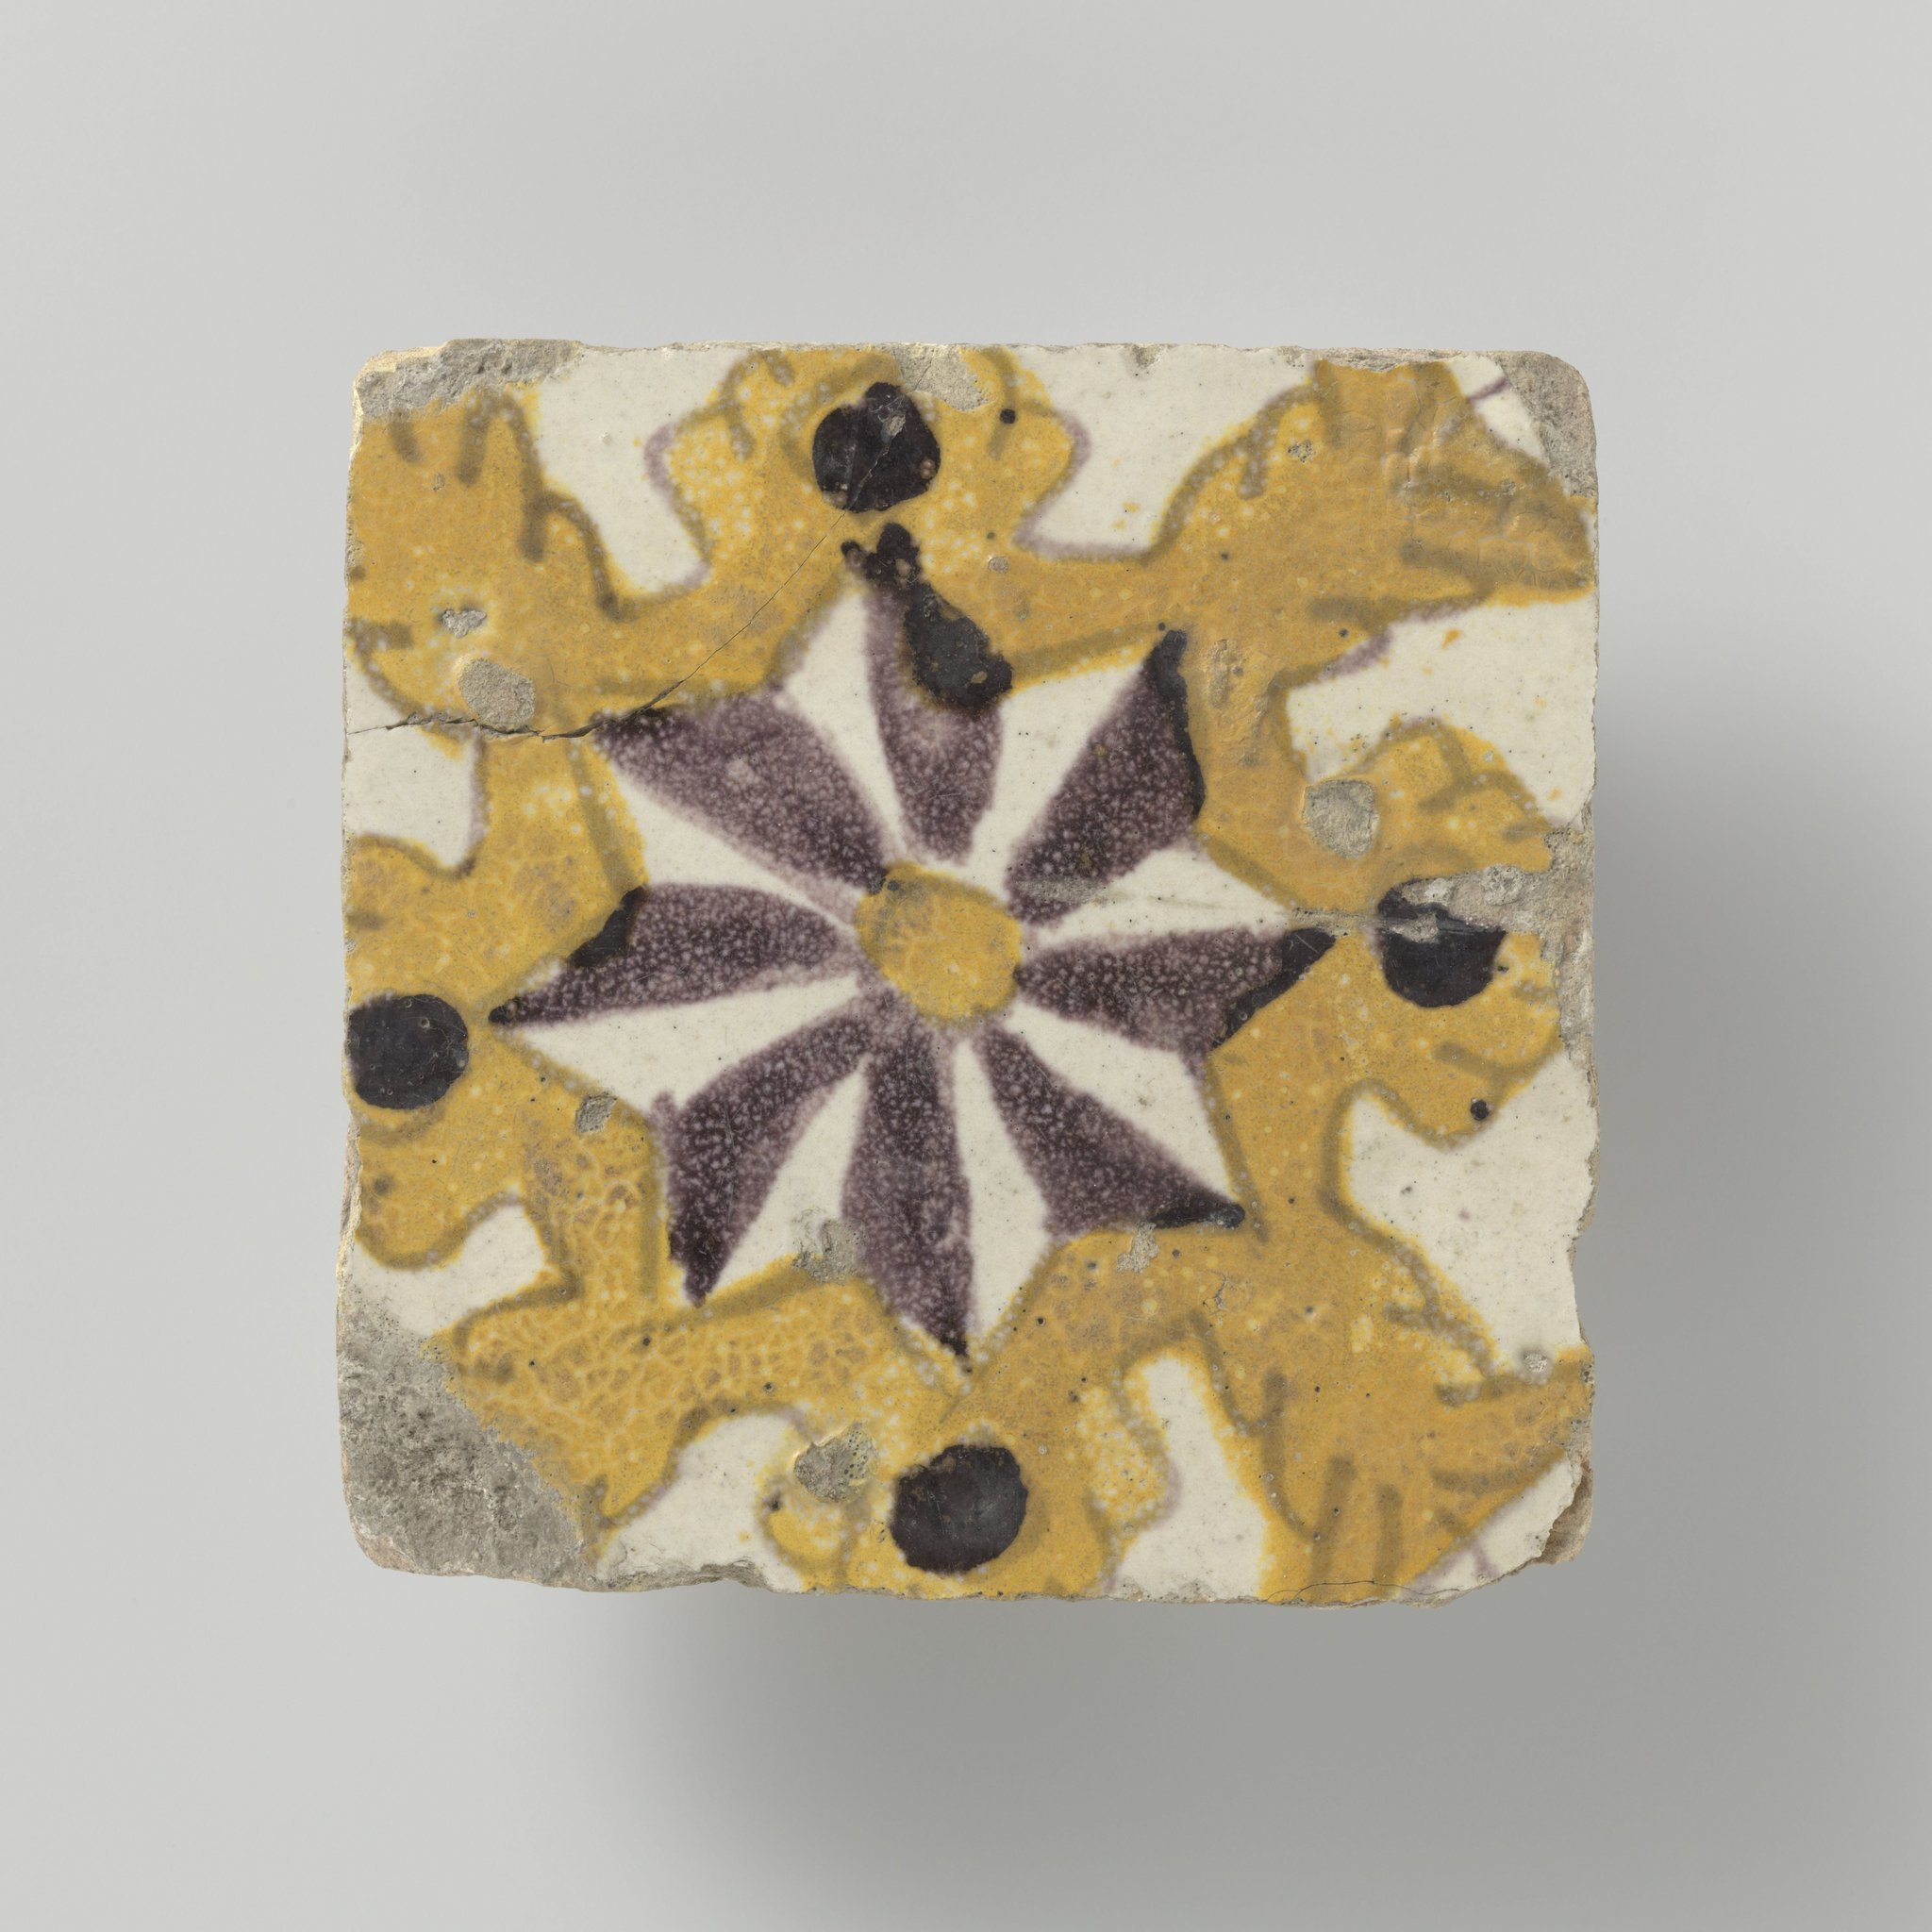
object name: tile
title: Tegel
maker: Anonymous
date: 1600-1800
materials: earthenware, glaze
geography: tunisia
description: Tegel, beschilderd in geel, mangaan. Gelobd rozet, waarin een achtpuntige ster. In de hoeken kwart achthoeken, met een dunne lijn met het rozet verbonden.